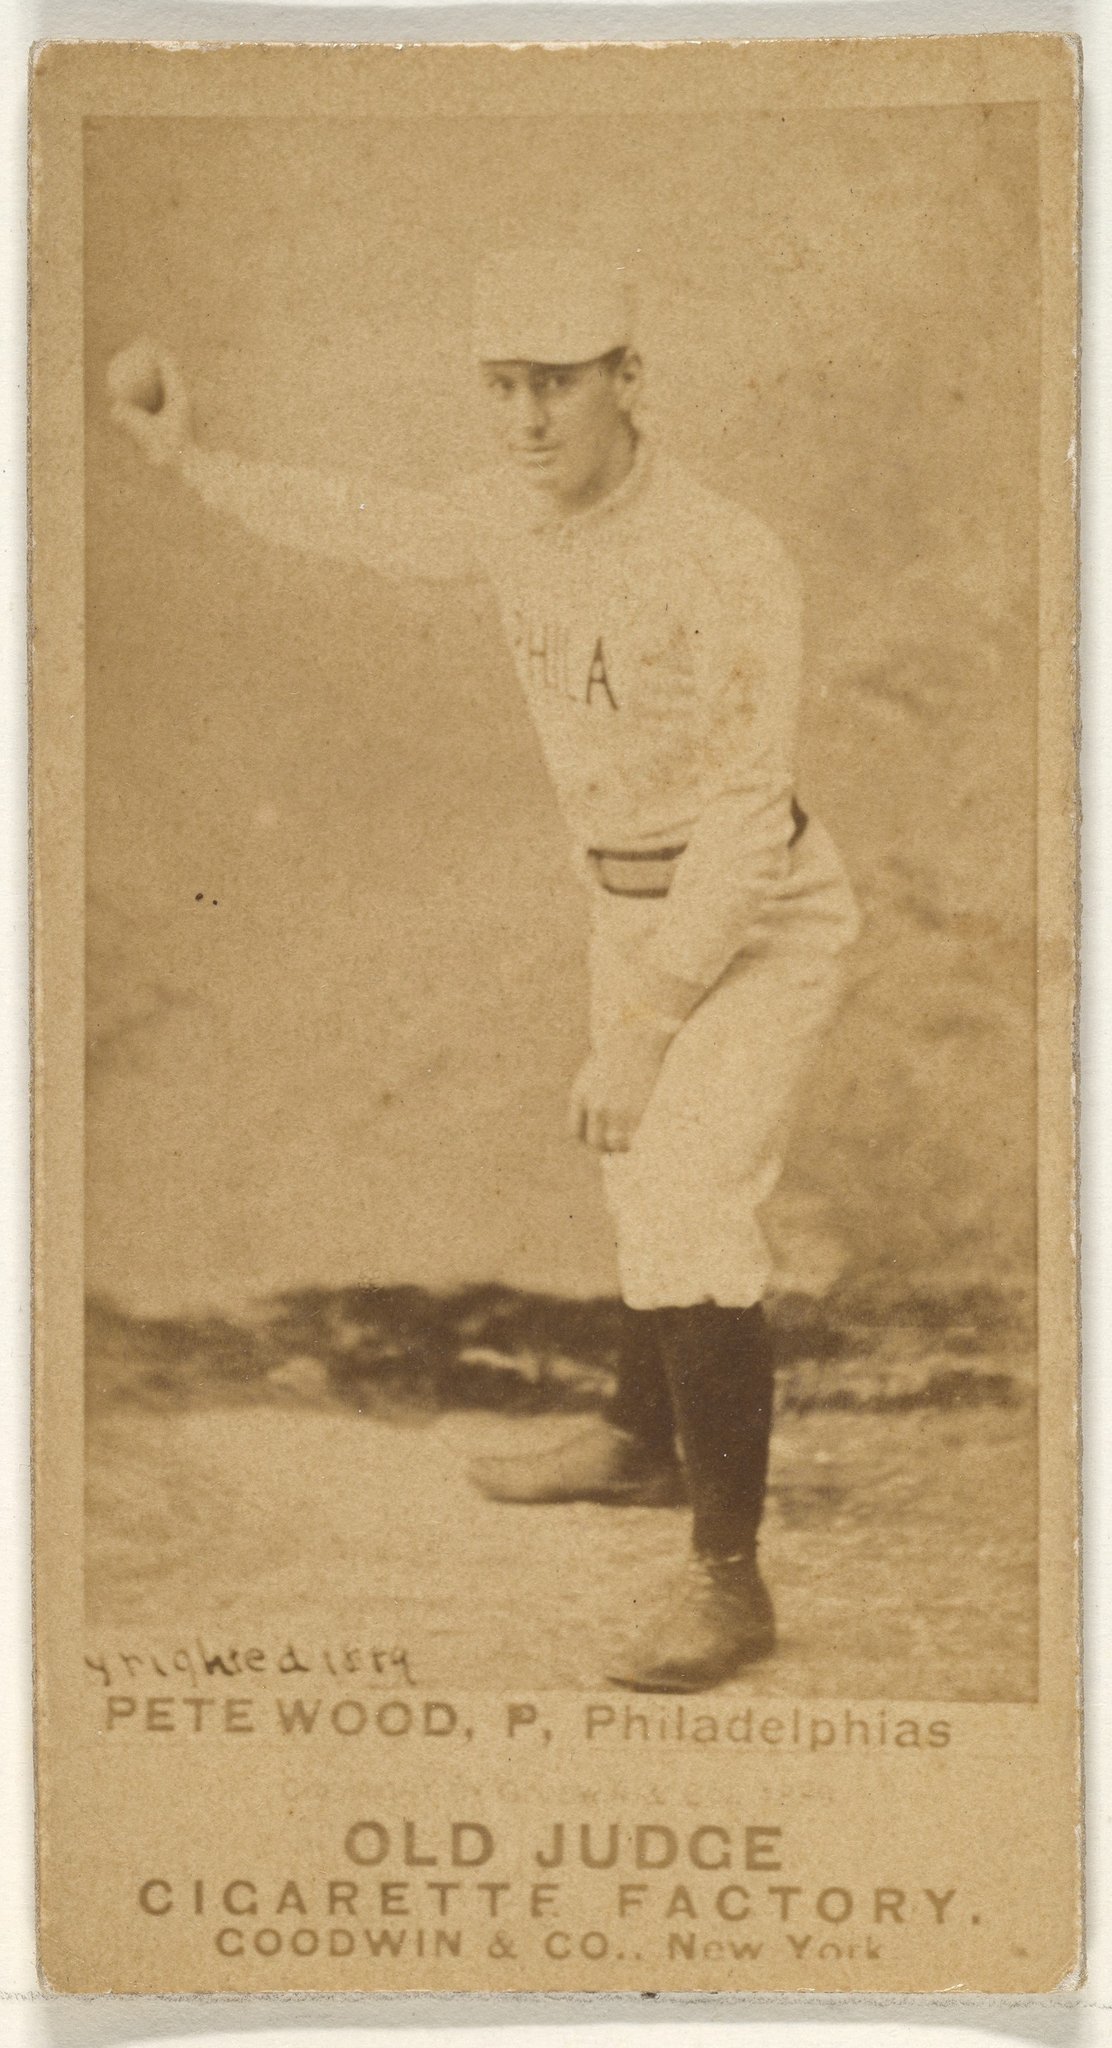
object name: baseball card, photograph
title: Peter Burke "Pete" Wood, Pitcher, Philadelphia, from the Old Judge series (N172) for Old Judge Cigarettes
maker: goodwin & company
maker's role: publisher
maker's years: 1850-1950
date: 1889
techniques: albumen silver print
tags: men,portraits,baseball,athletes